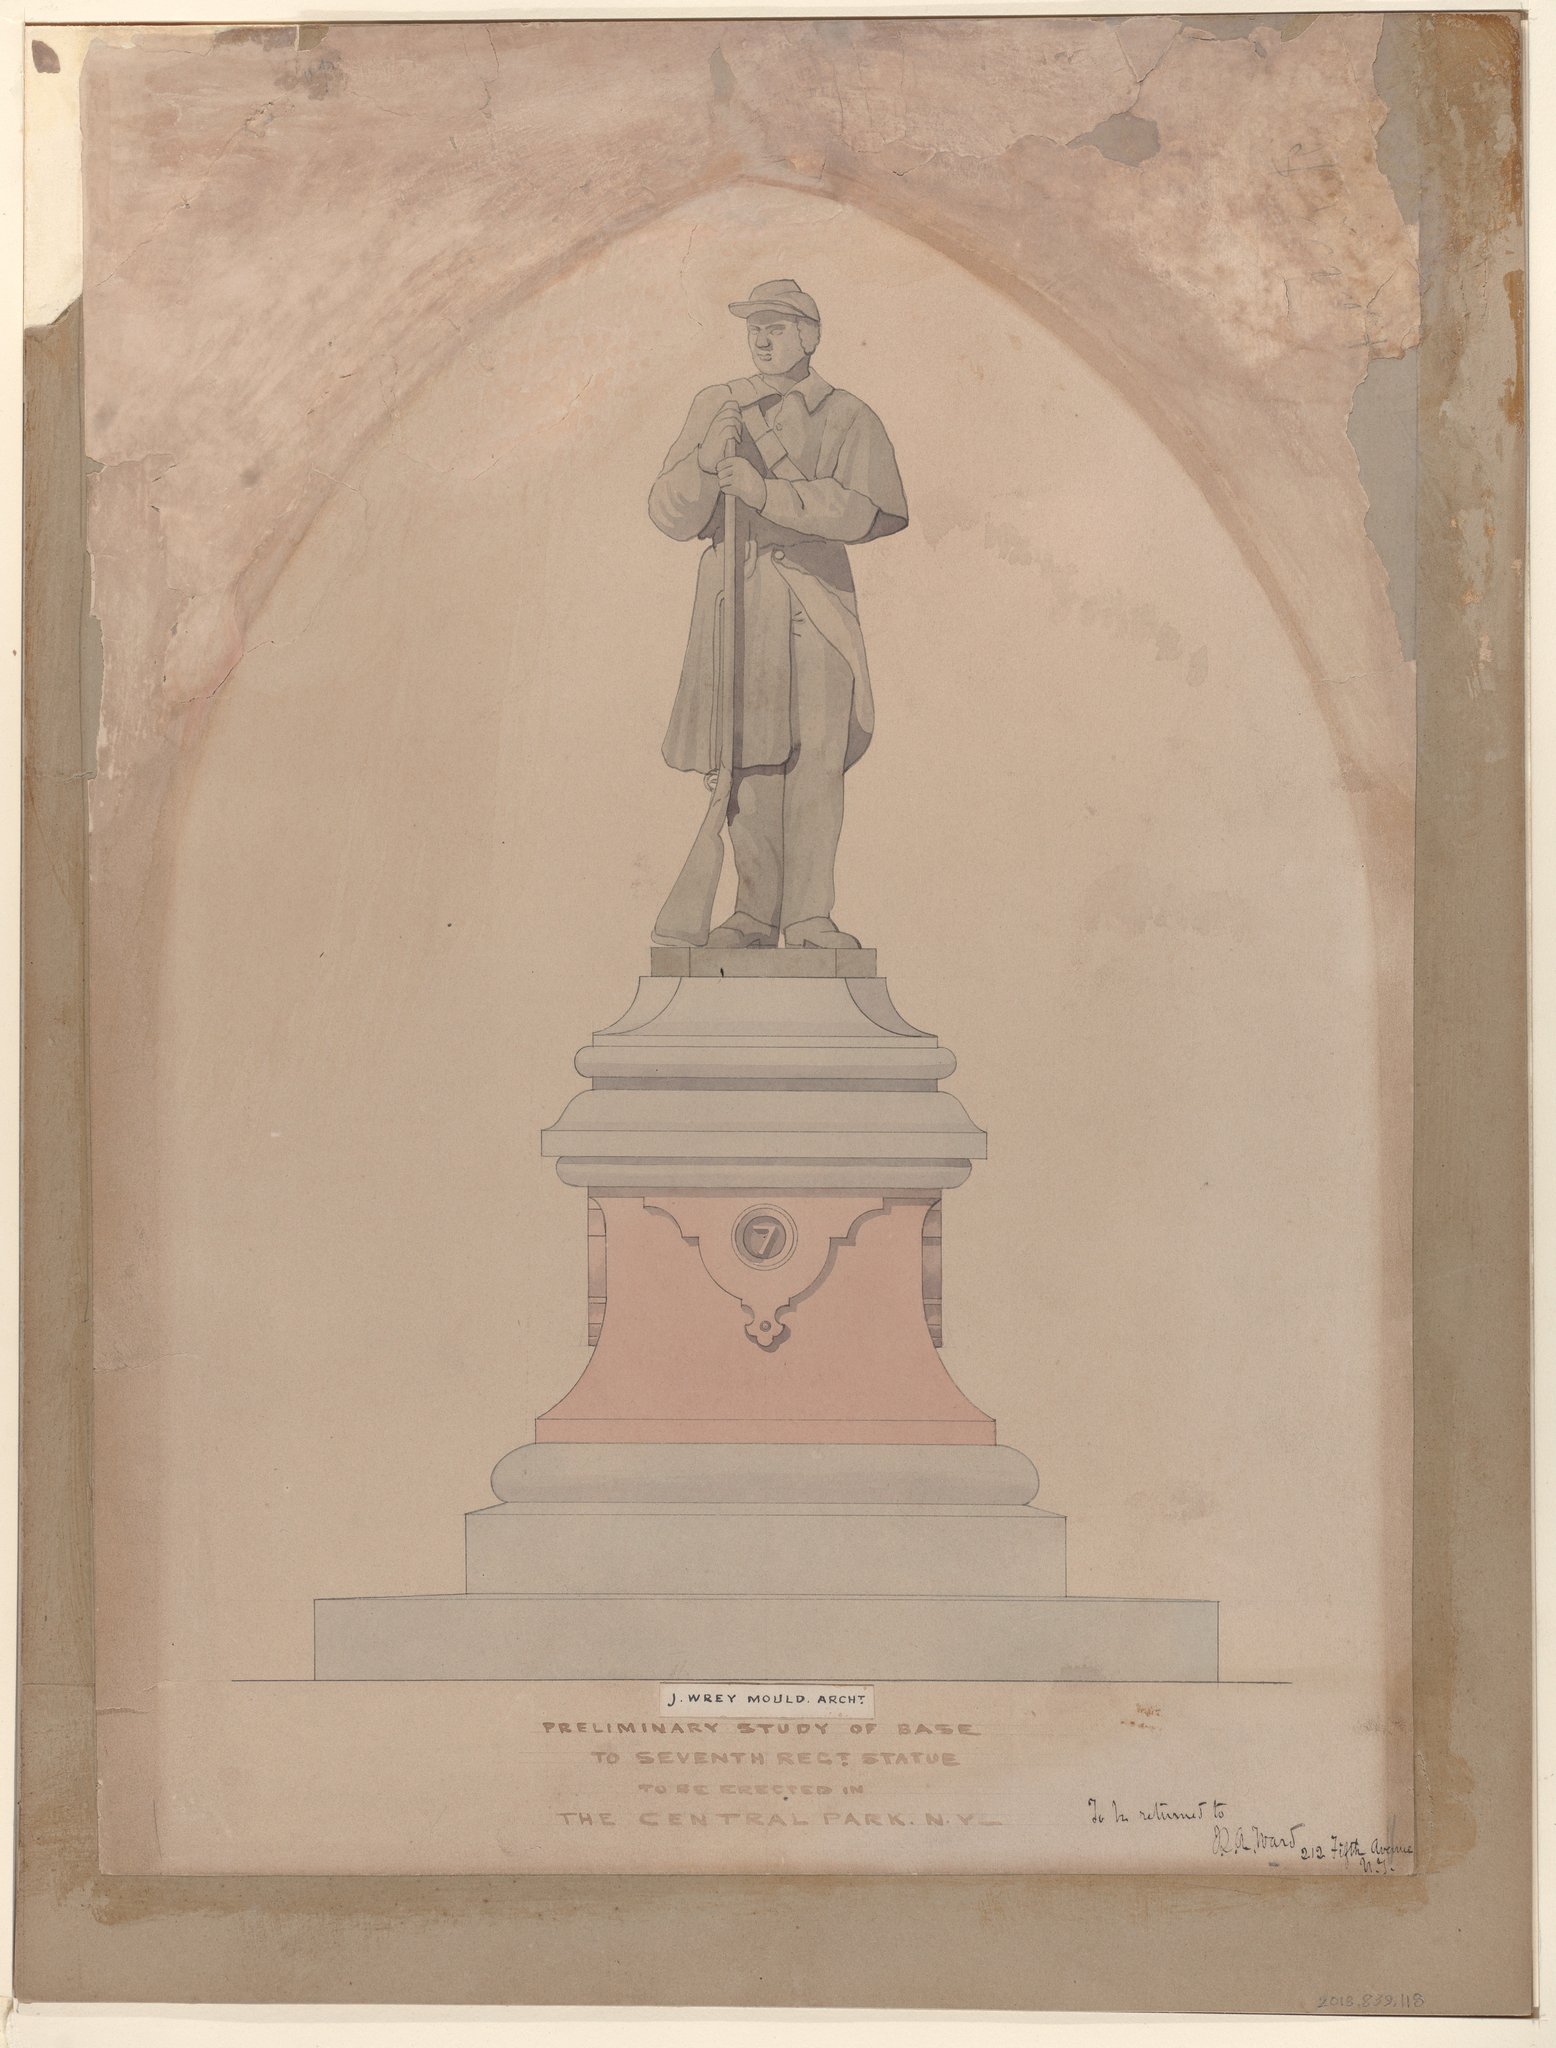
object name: drawing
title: Pedestal Design for the Seventh Regiment Memorial in Central Park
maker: jacob wrey mould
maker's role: artist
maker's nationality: american, born england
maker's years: 1825-1886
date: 1868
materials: ink, watercolor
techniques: pen